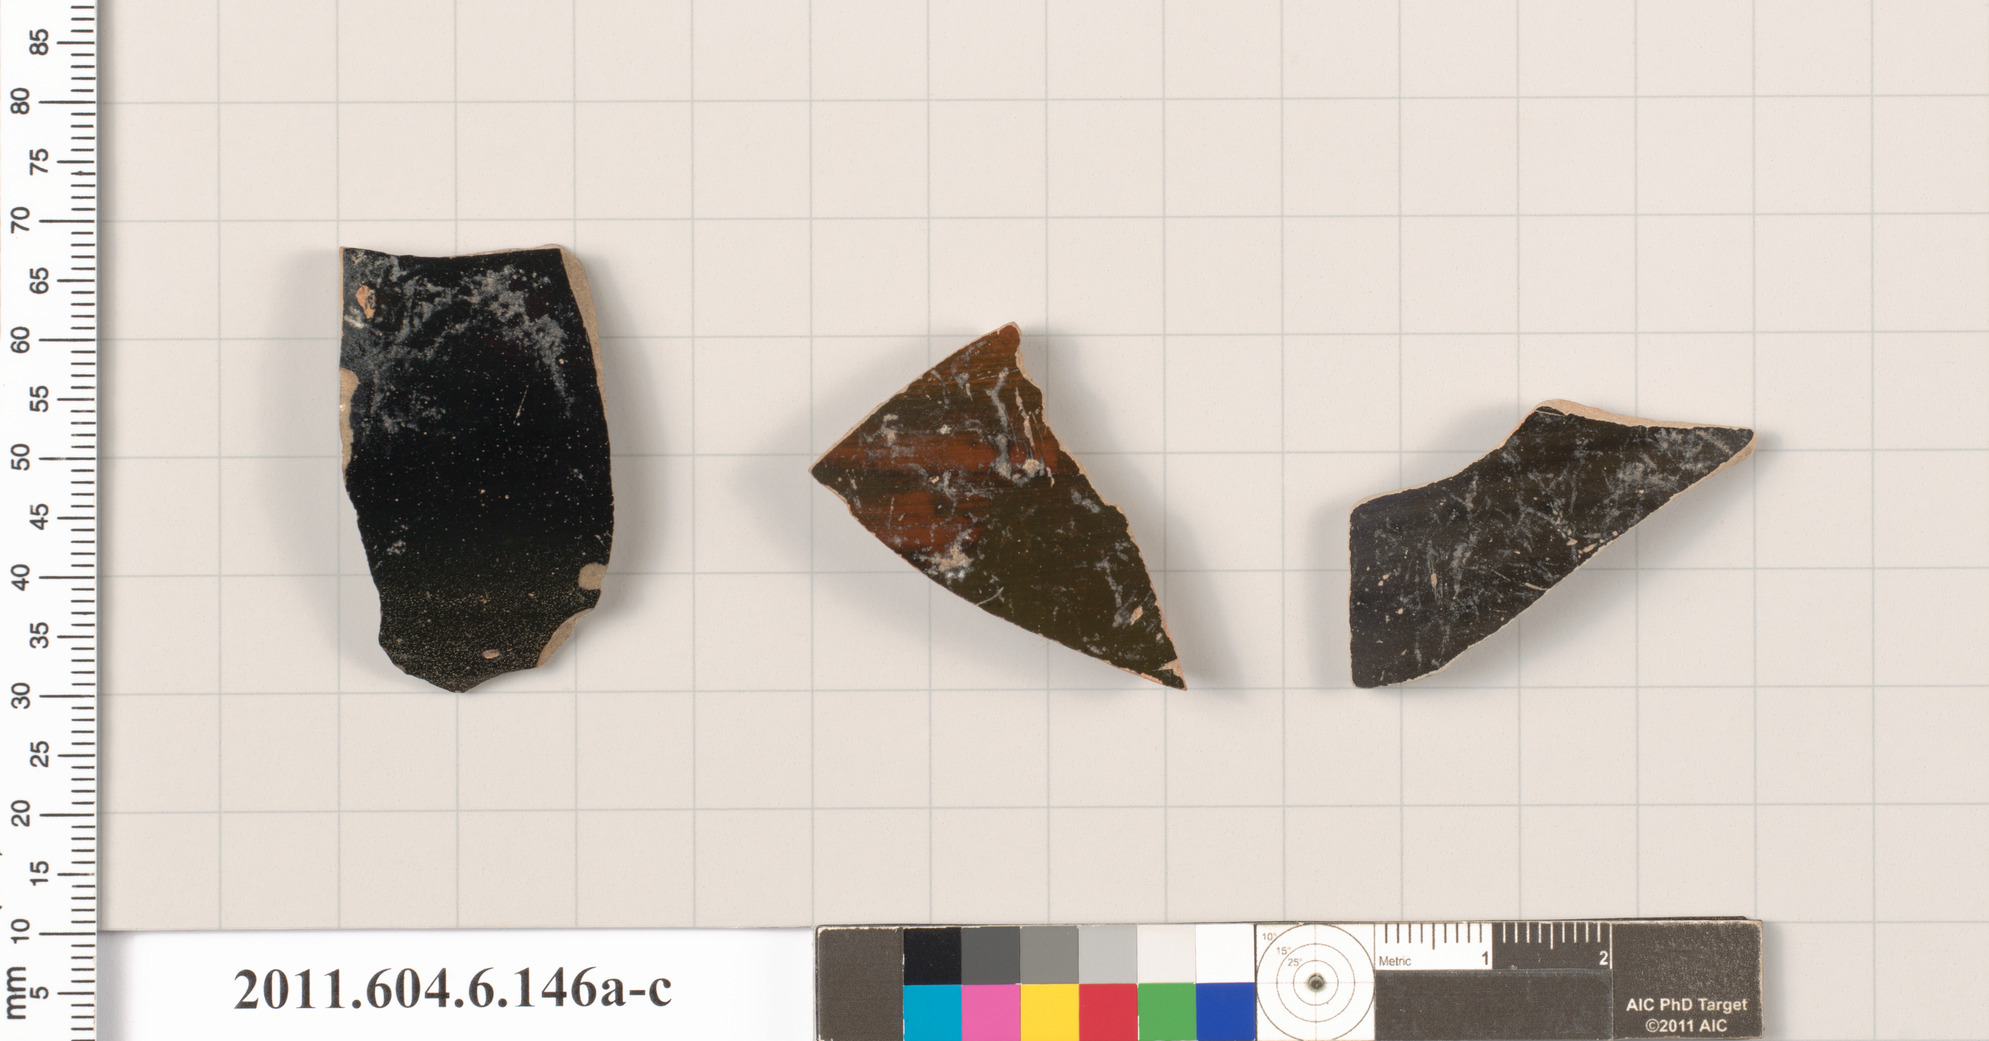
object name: undetermined open shape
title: Terracotta fragments of open shapes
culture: greek, attic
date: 600-401 BCE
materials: terracotta